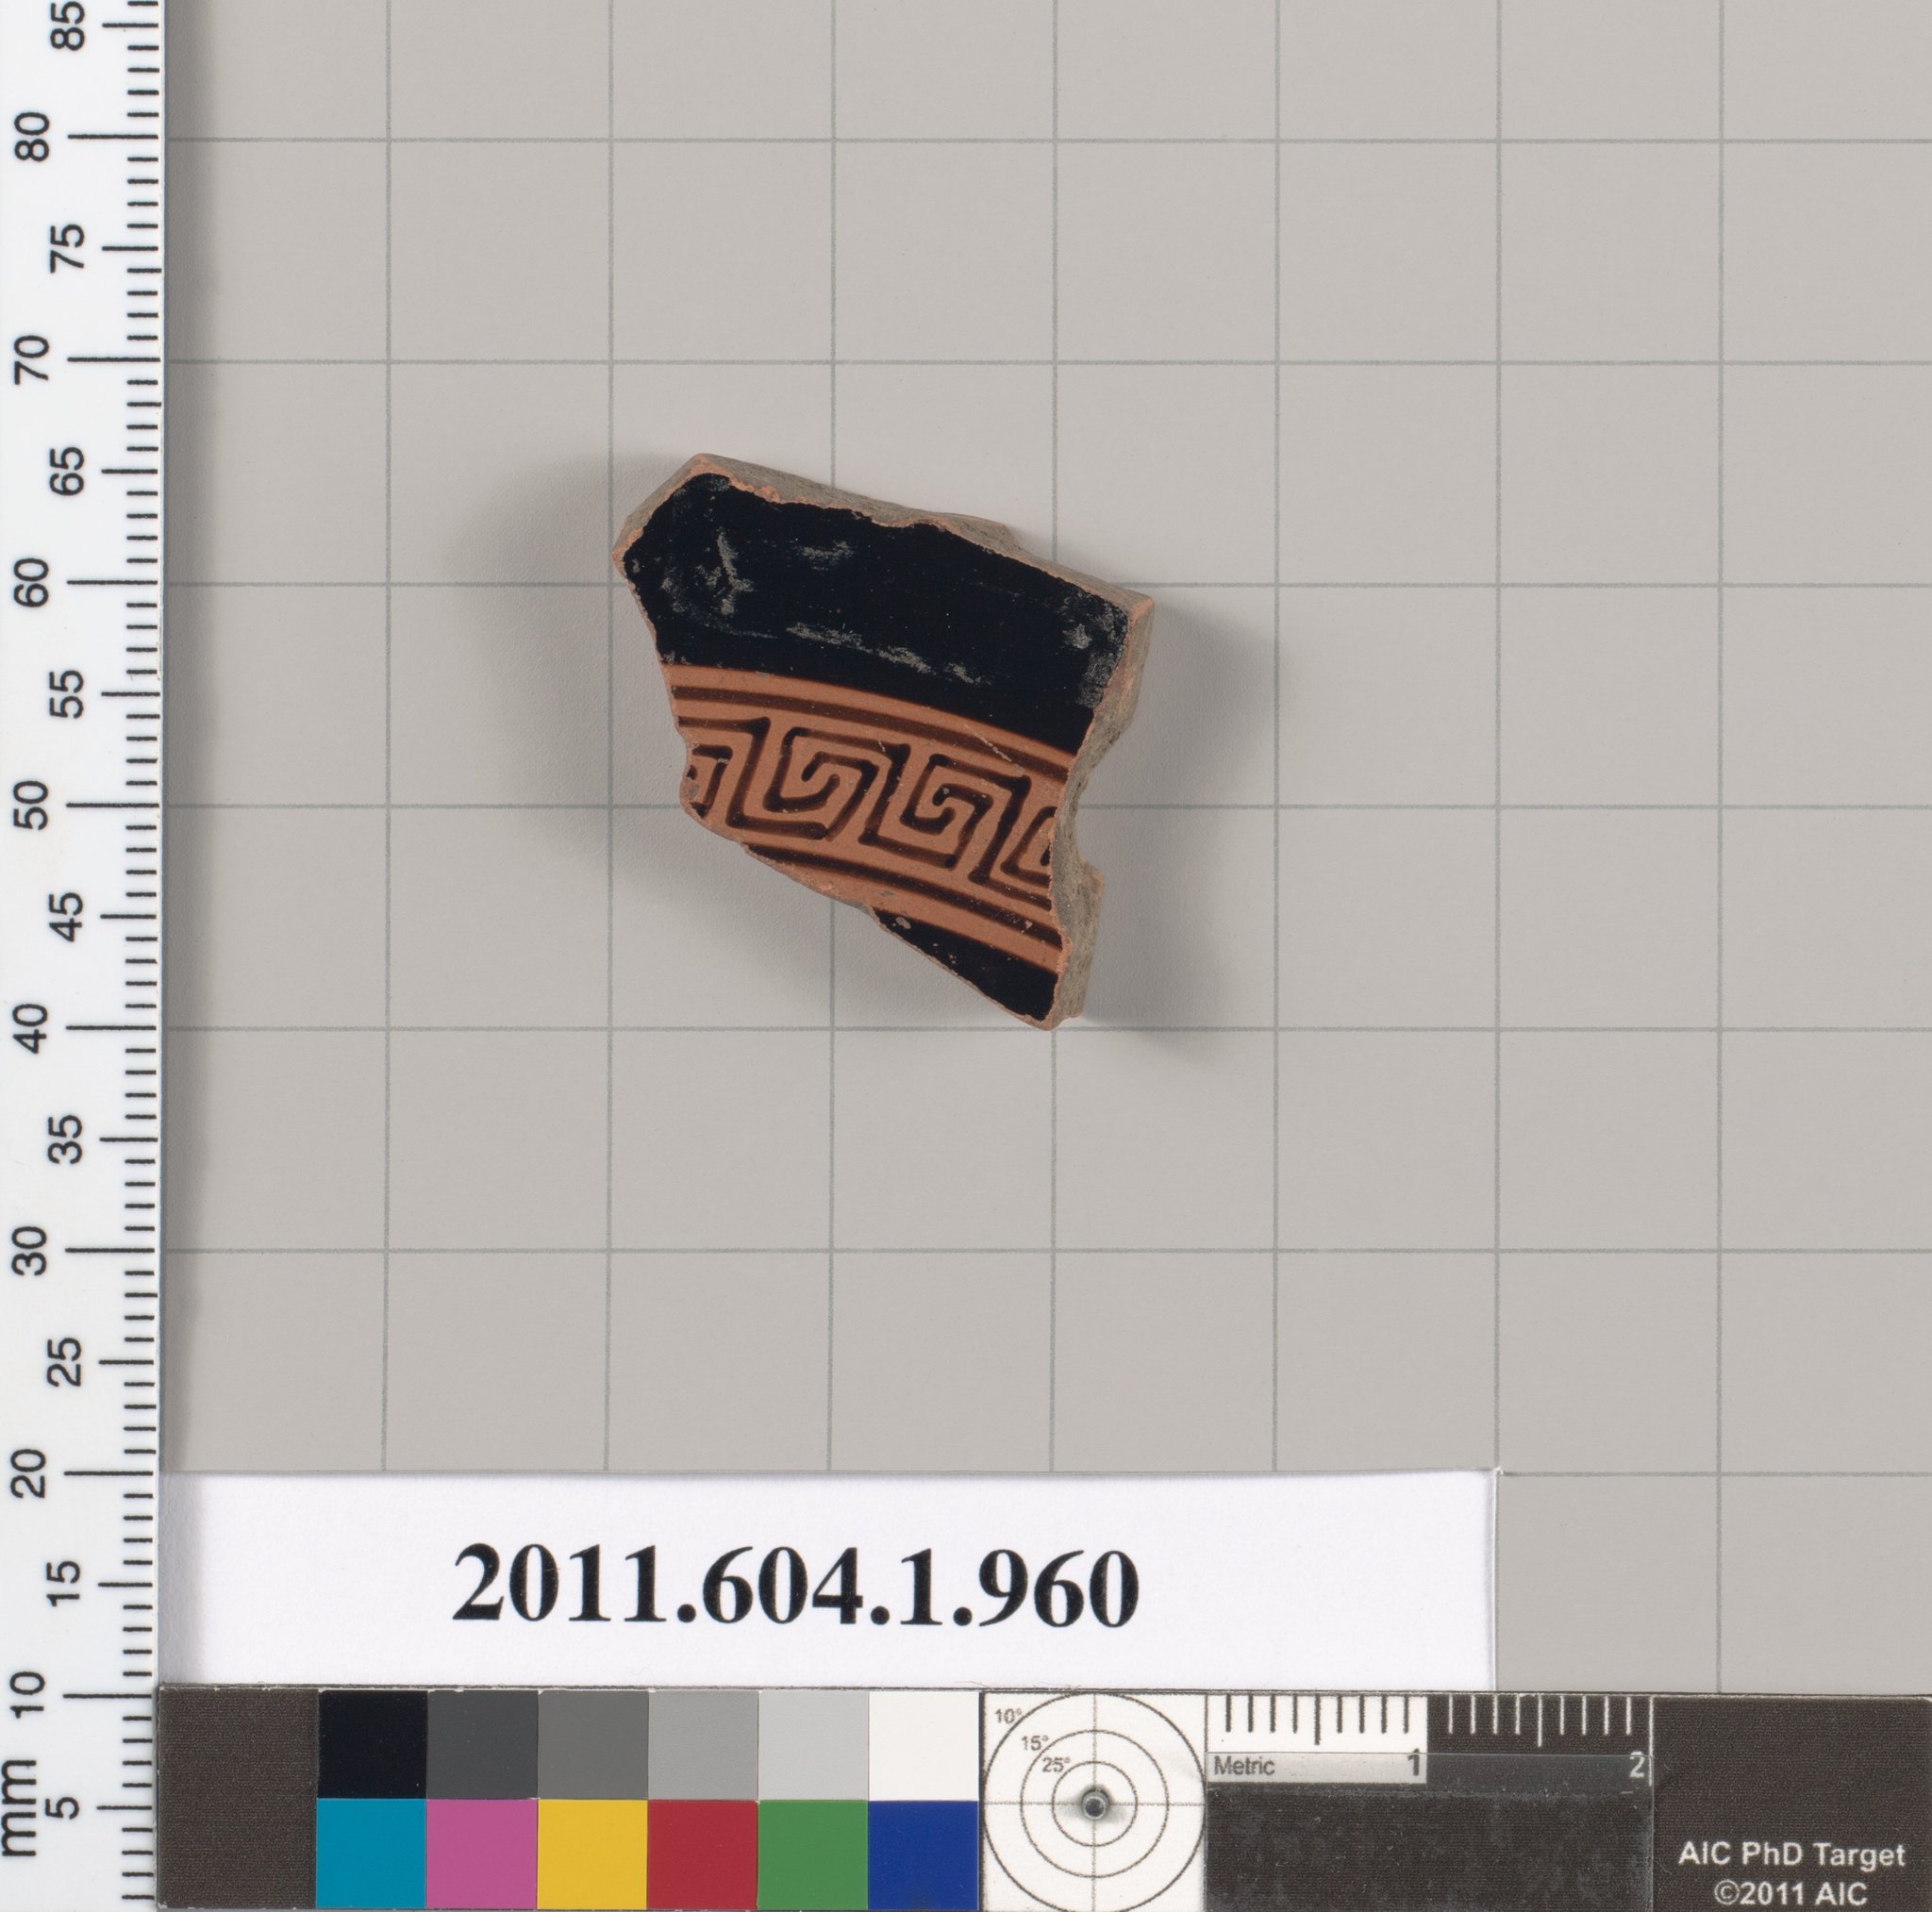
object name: kylix fragment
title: Terracotta fragment of a kylix (drinking cup)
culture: greek, attic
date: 490-480 BCE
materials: terracotta